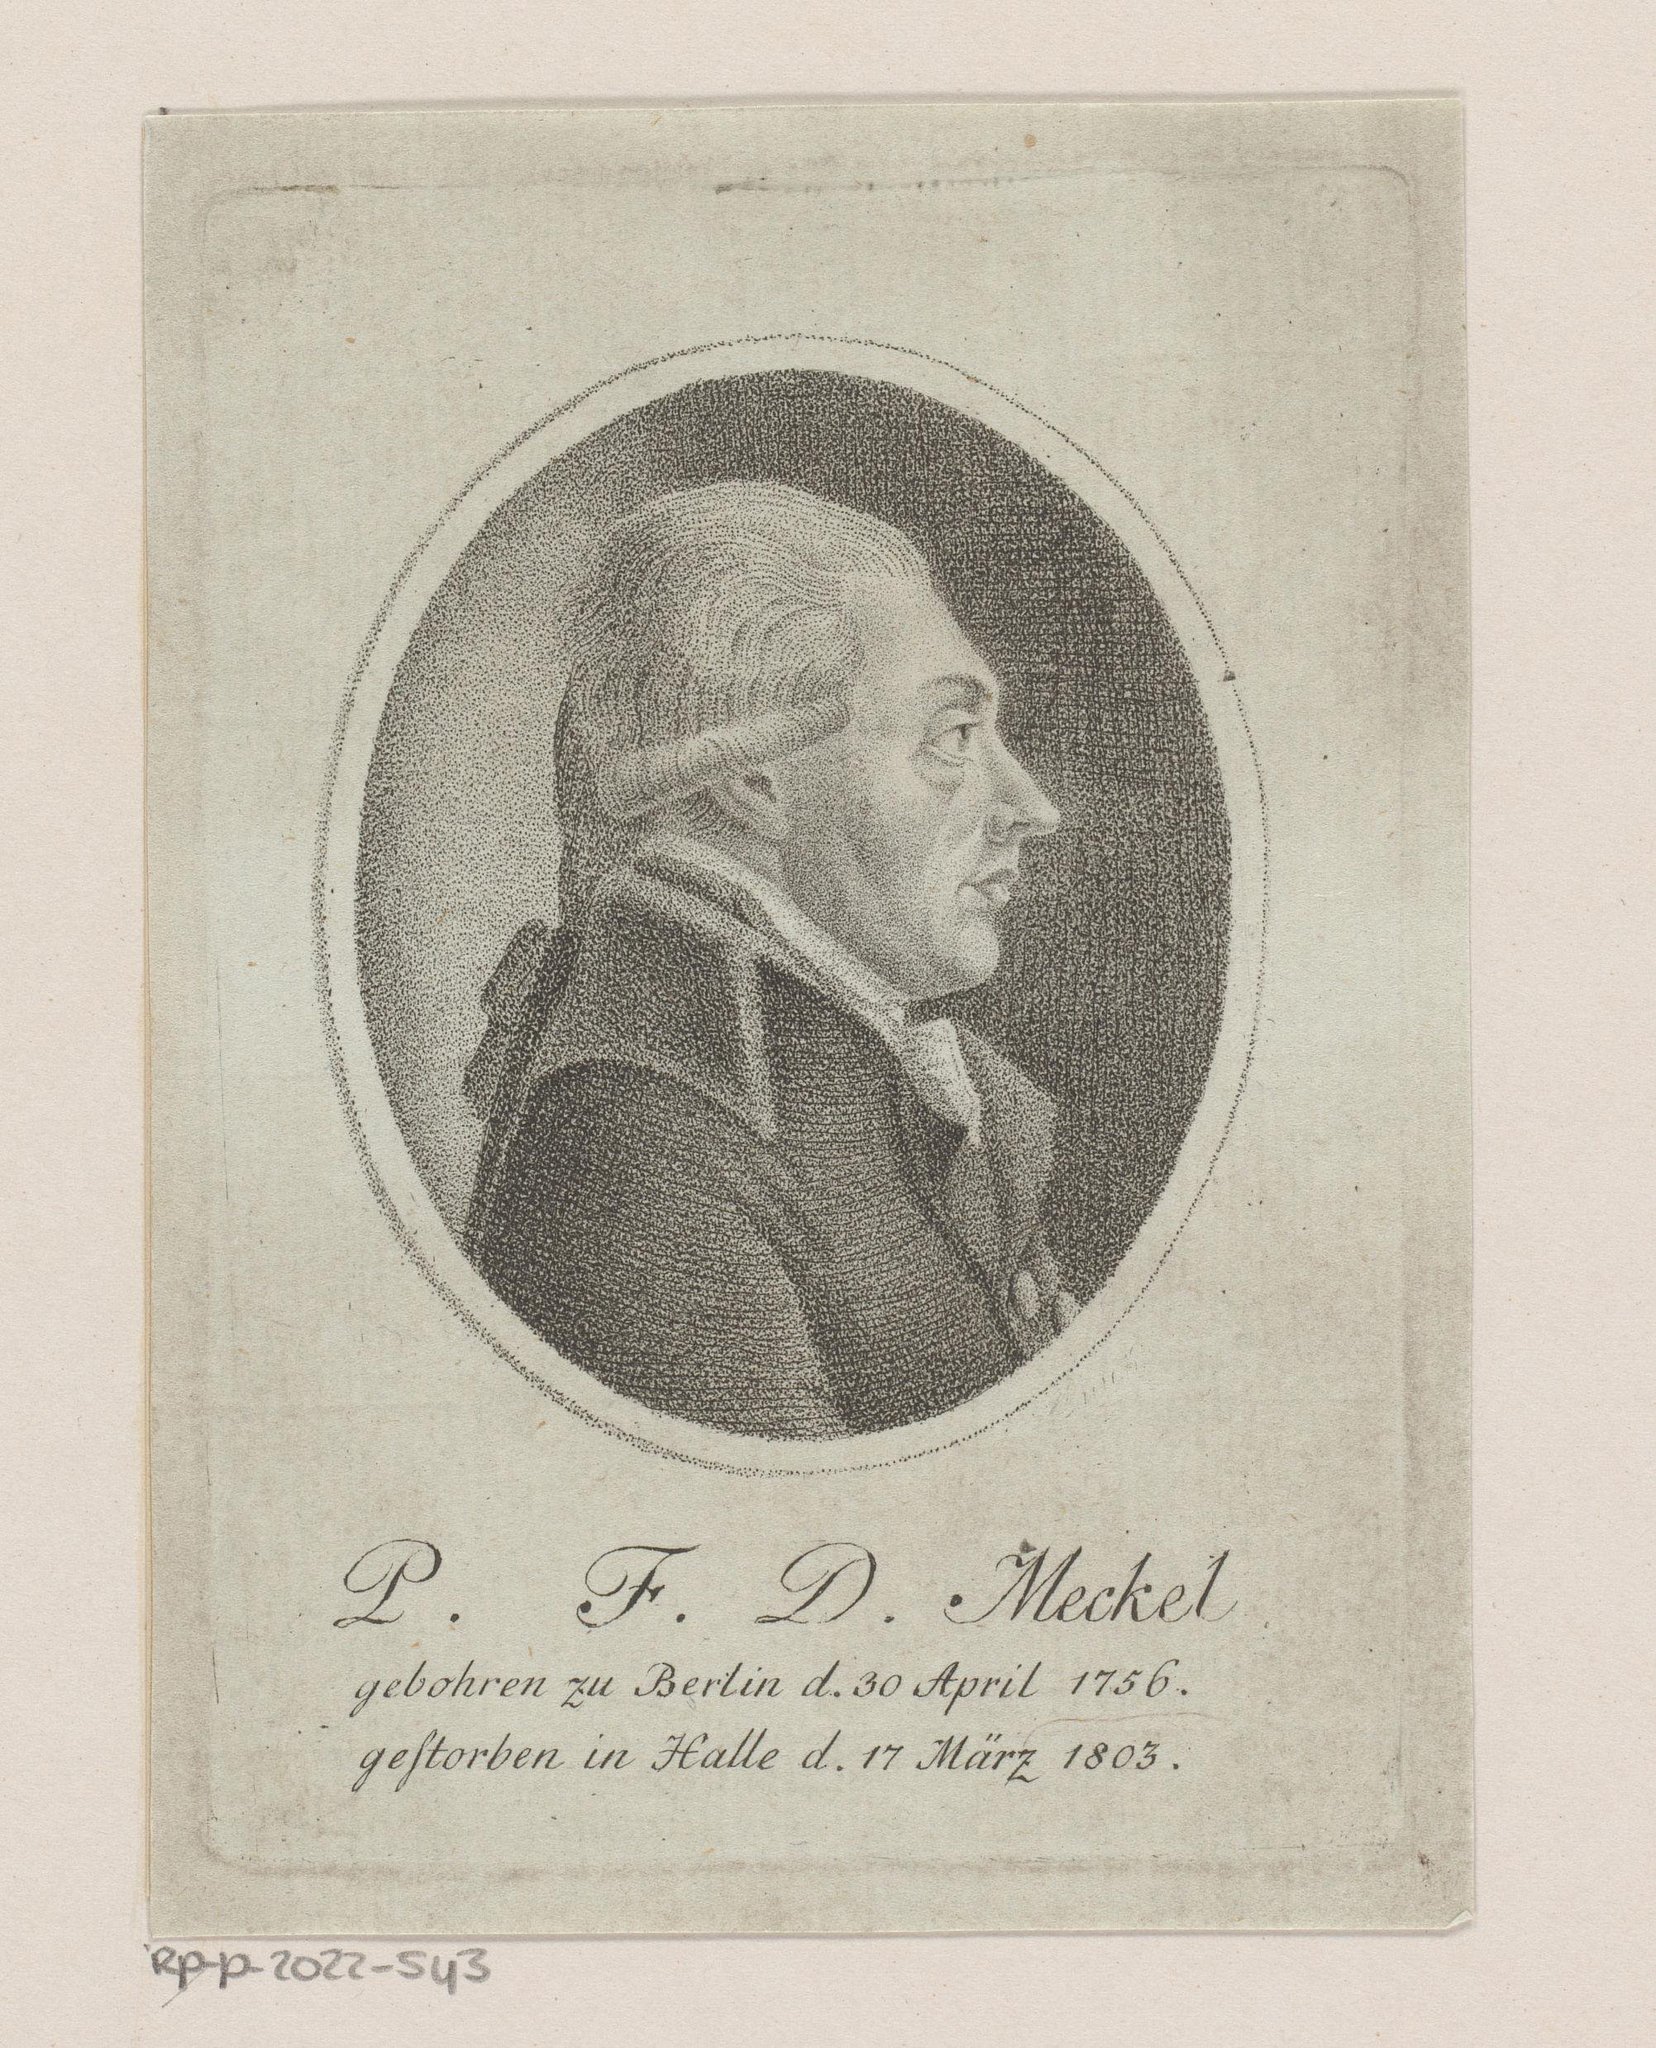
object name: print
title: P. F. D. Meckel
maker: Anonymous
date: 1780-1850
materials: paper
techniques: etching, roulette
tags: berlin, historical persons, professor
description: Met tweeregelig onderschrift in het Duits.